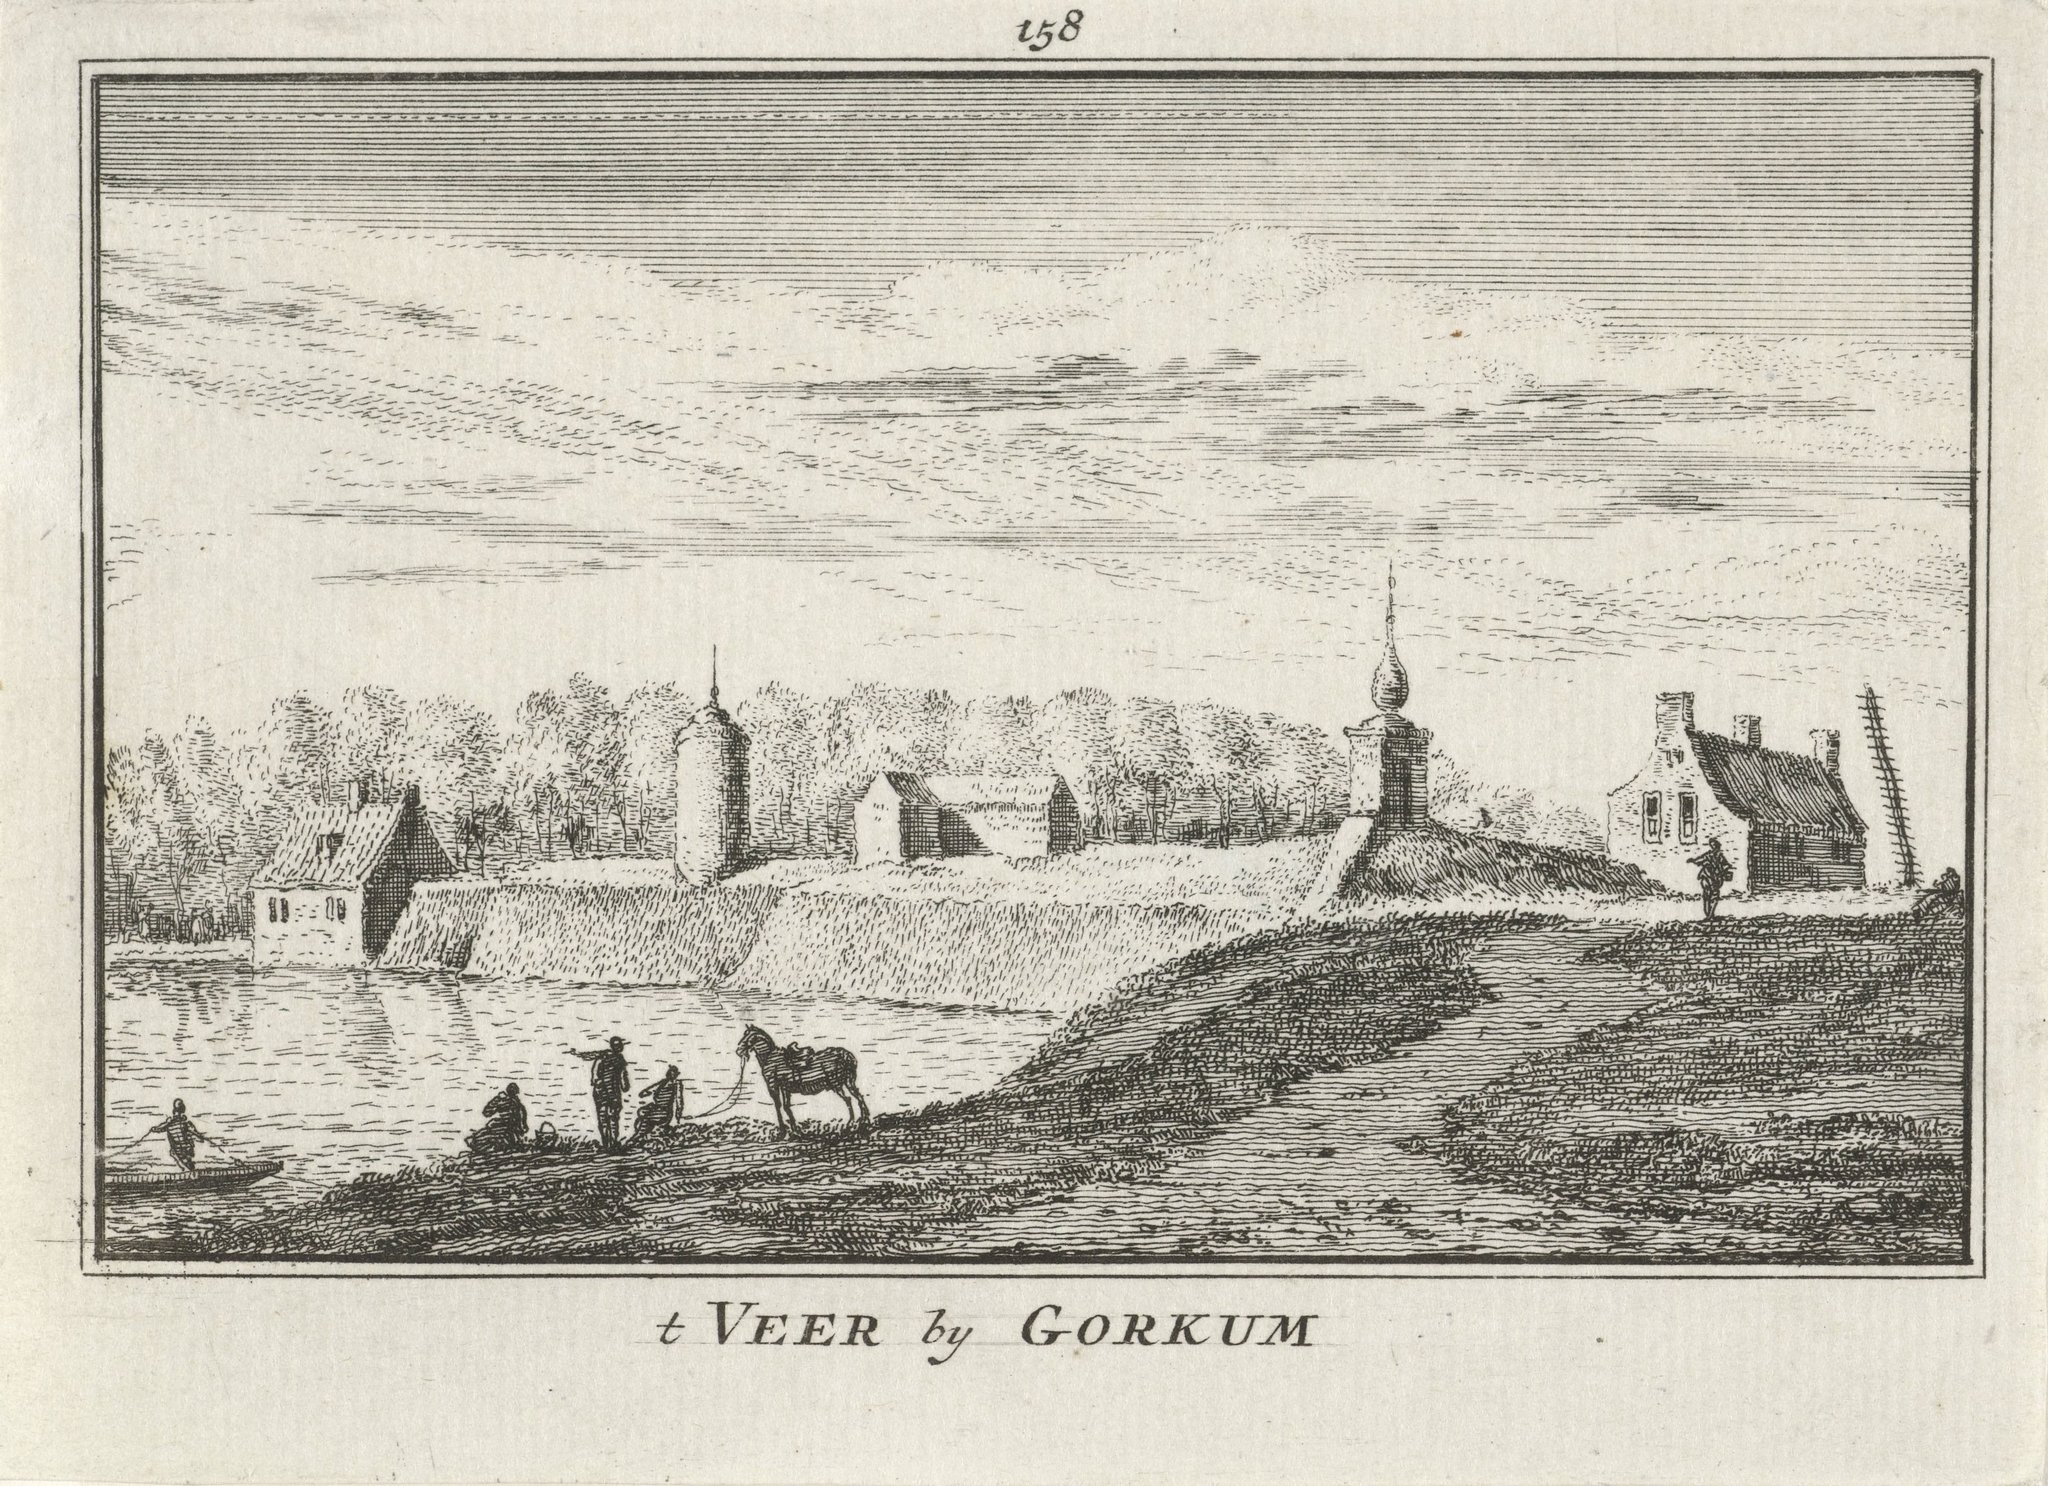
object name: print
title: t Veer by Gorkum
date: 1727-1733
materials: paper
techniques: etching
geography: amsterdam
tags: ferry, city-walls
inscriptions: collector's mark: Lugt 2228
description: Illustratie uit: Abraham Rademaker, Matthaeus Brouërius van Niedek, Isaac Le Long, Kabinet van Nederlandsche en Kleefsche outheden en (...) voorname stads- en landgebouwen, Willem Barents en Antoni Schoonenburg: Amsterdam, 1727-1733, ill. nr. 158.